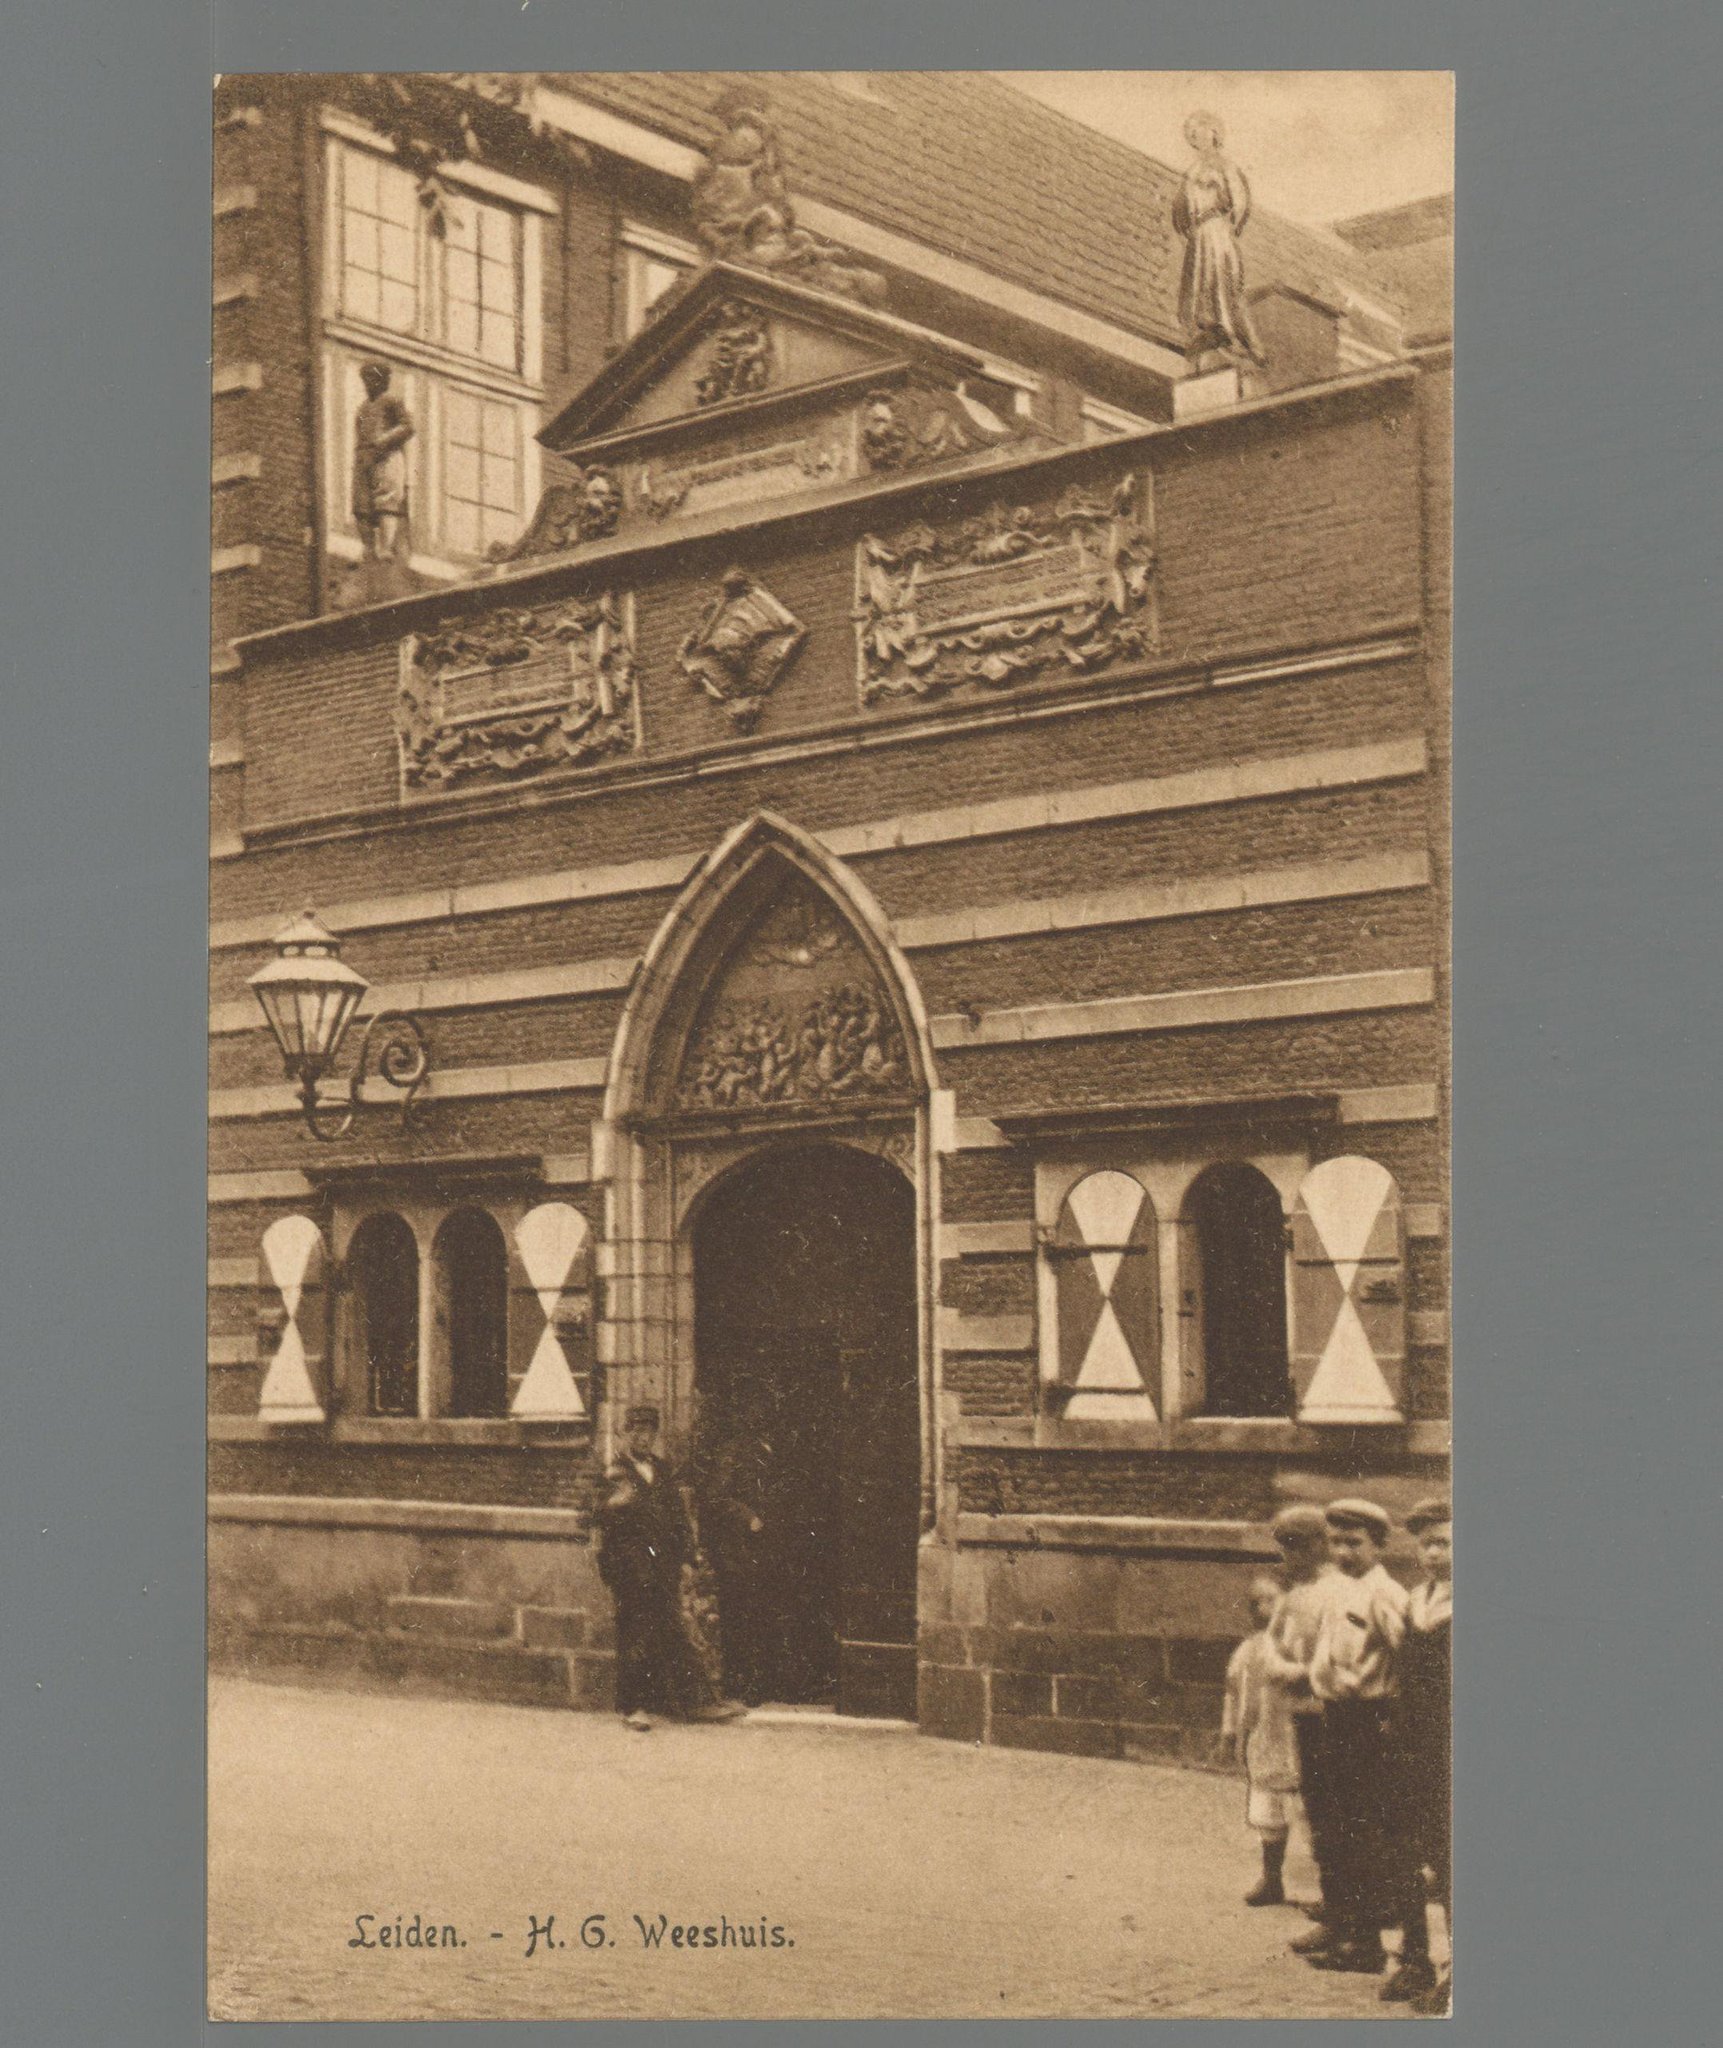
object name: ansichtkaart, prentbriefkaart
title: Leiden. - H.G. Weeshuis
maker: Anonymous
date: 1905-1930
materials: cardboard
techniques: photograph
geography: leiden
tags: orphanage